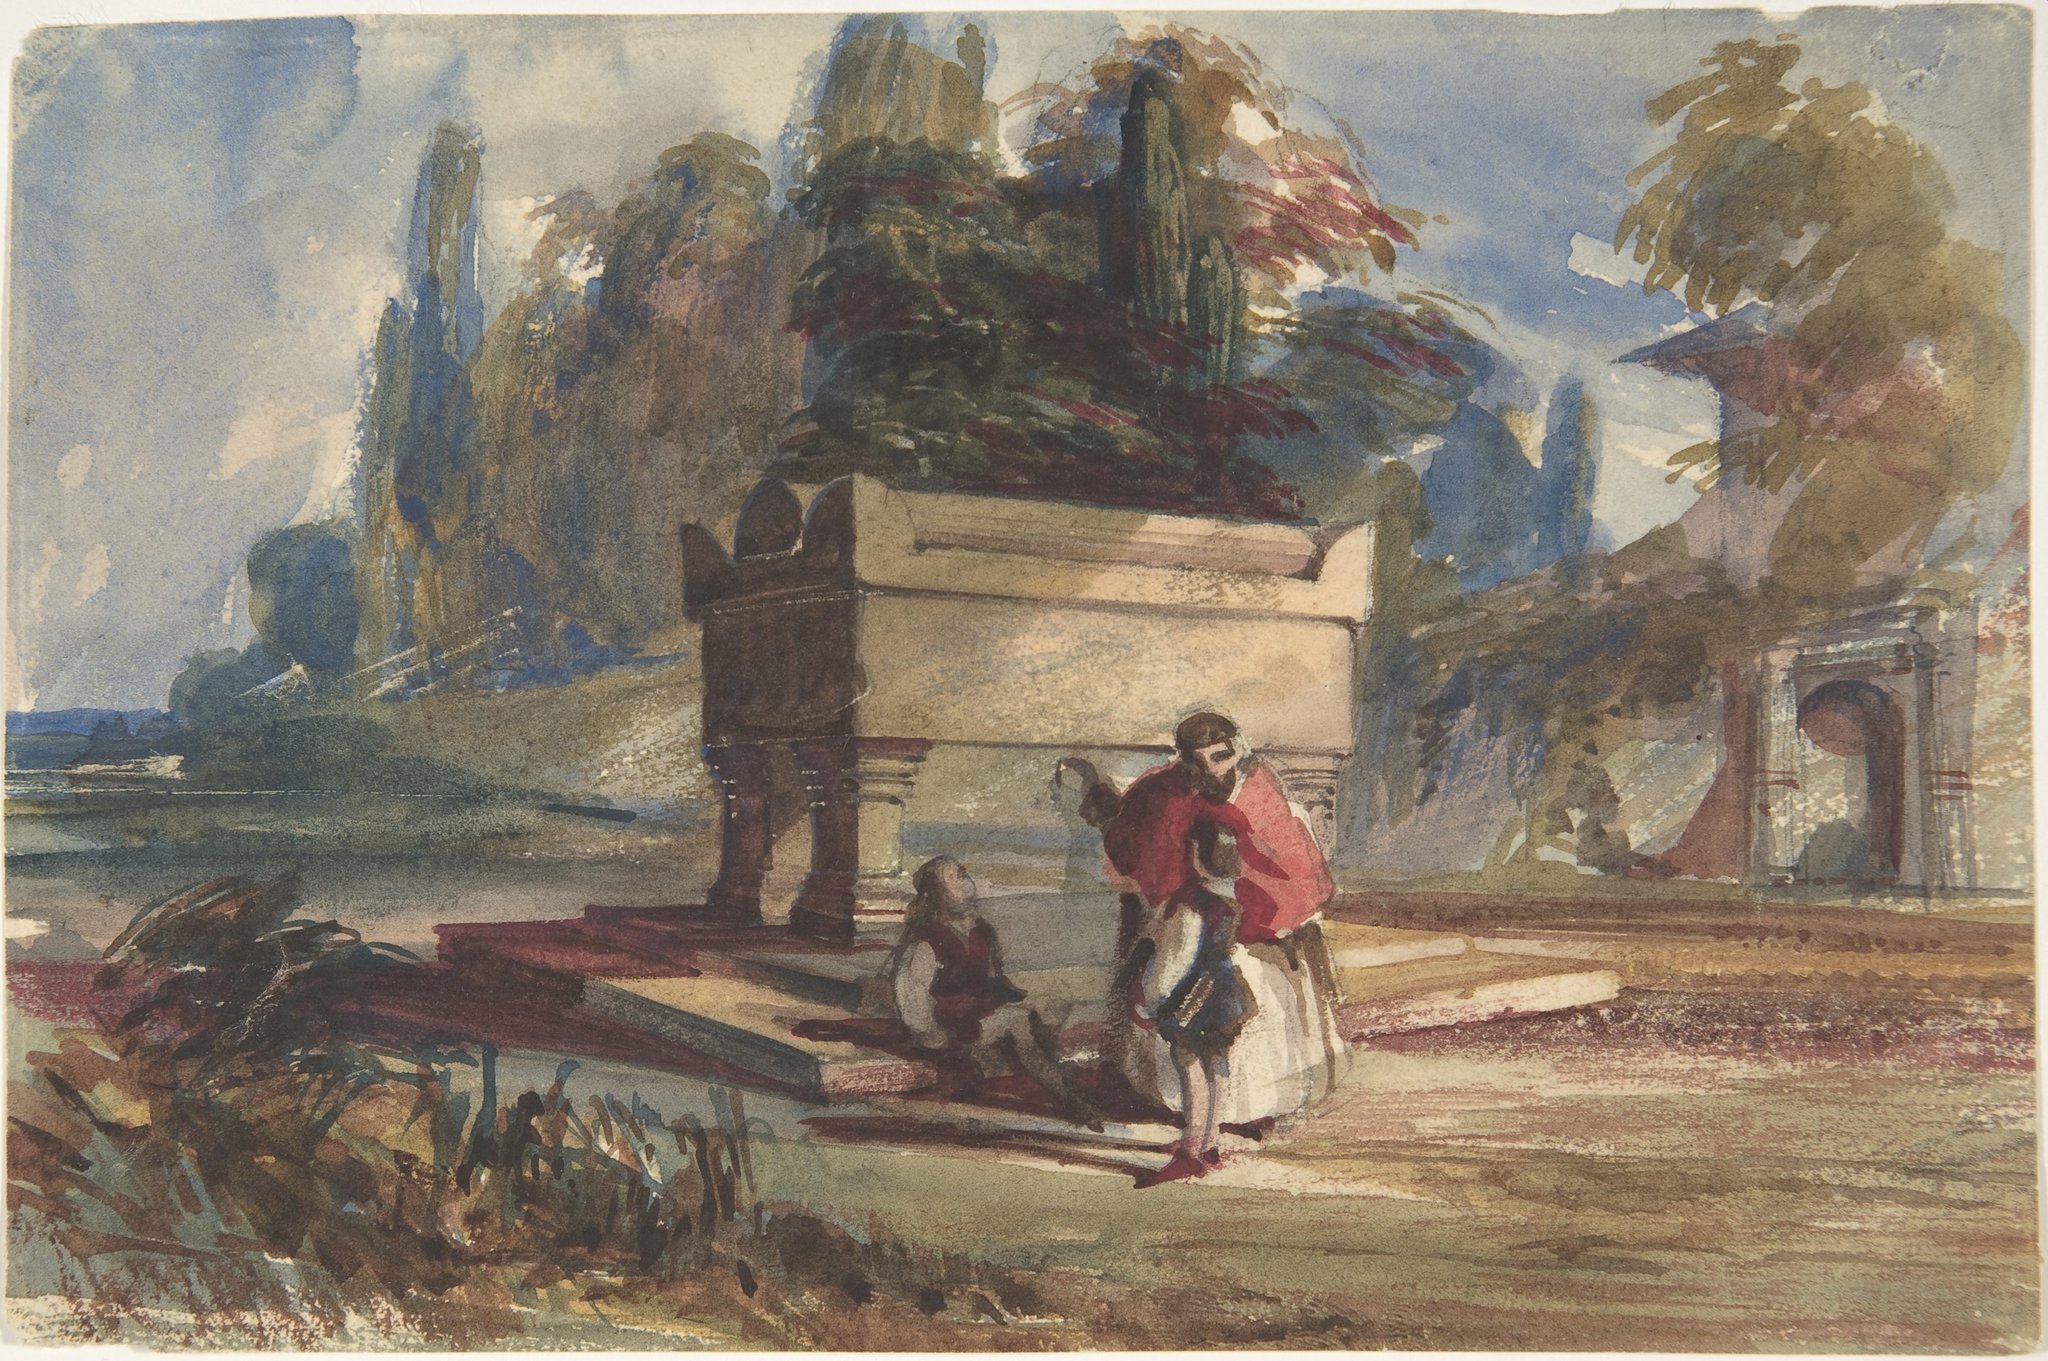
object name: drawing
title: Oriental Scene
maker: william james müller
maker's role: artist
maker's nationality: british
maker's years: 1812-1845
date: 1844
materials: chalk, watercolor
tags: men,landscapes